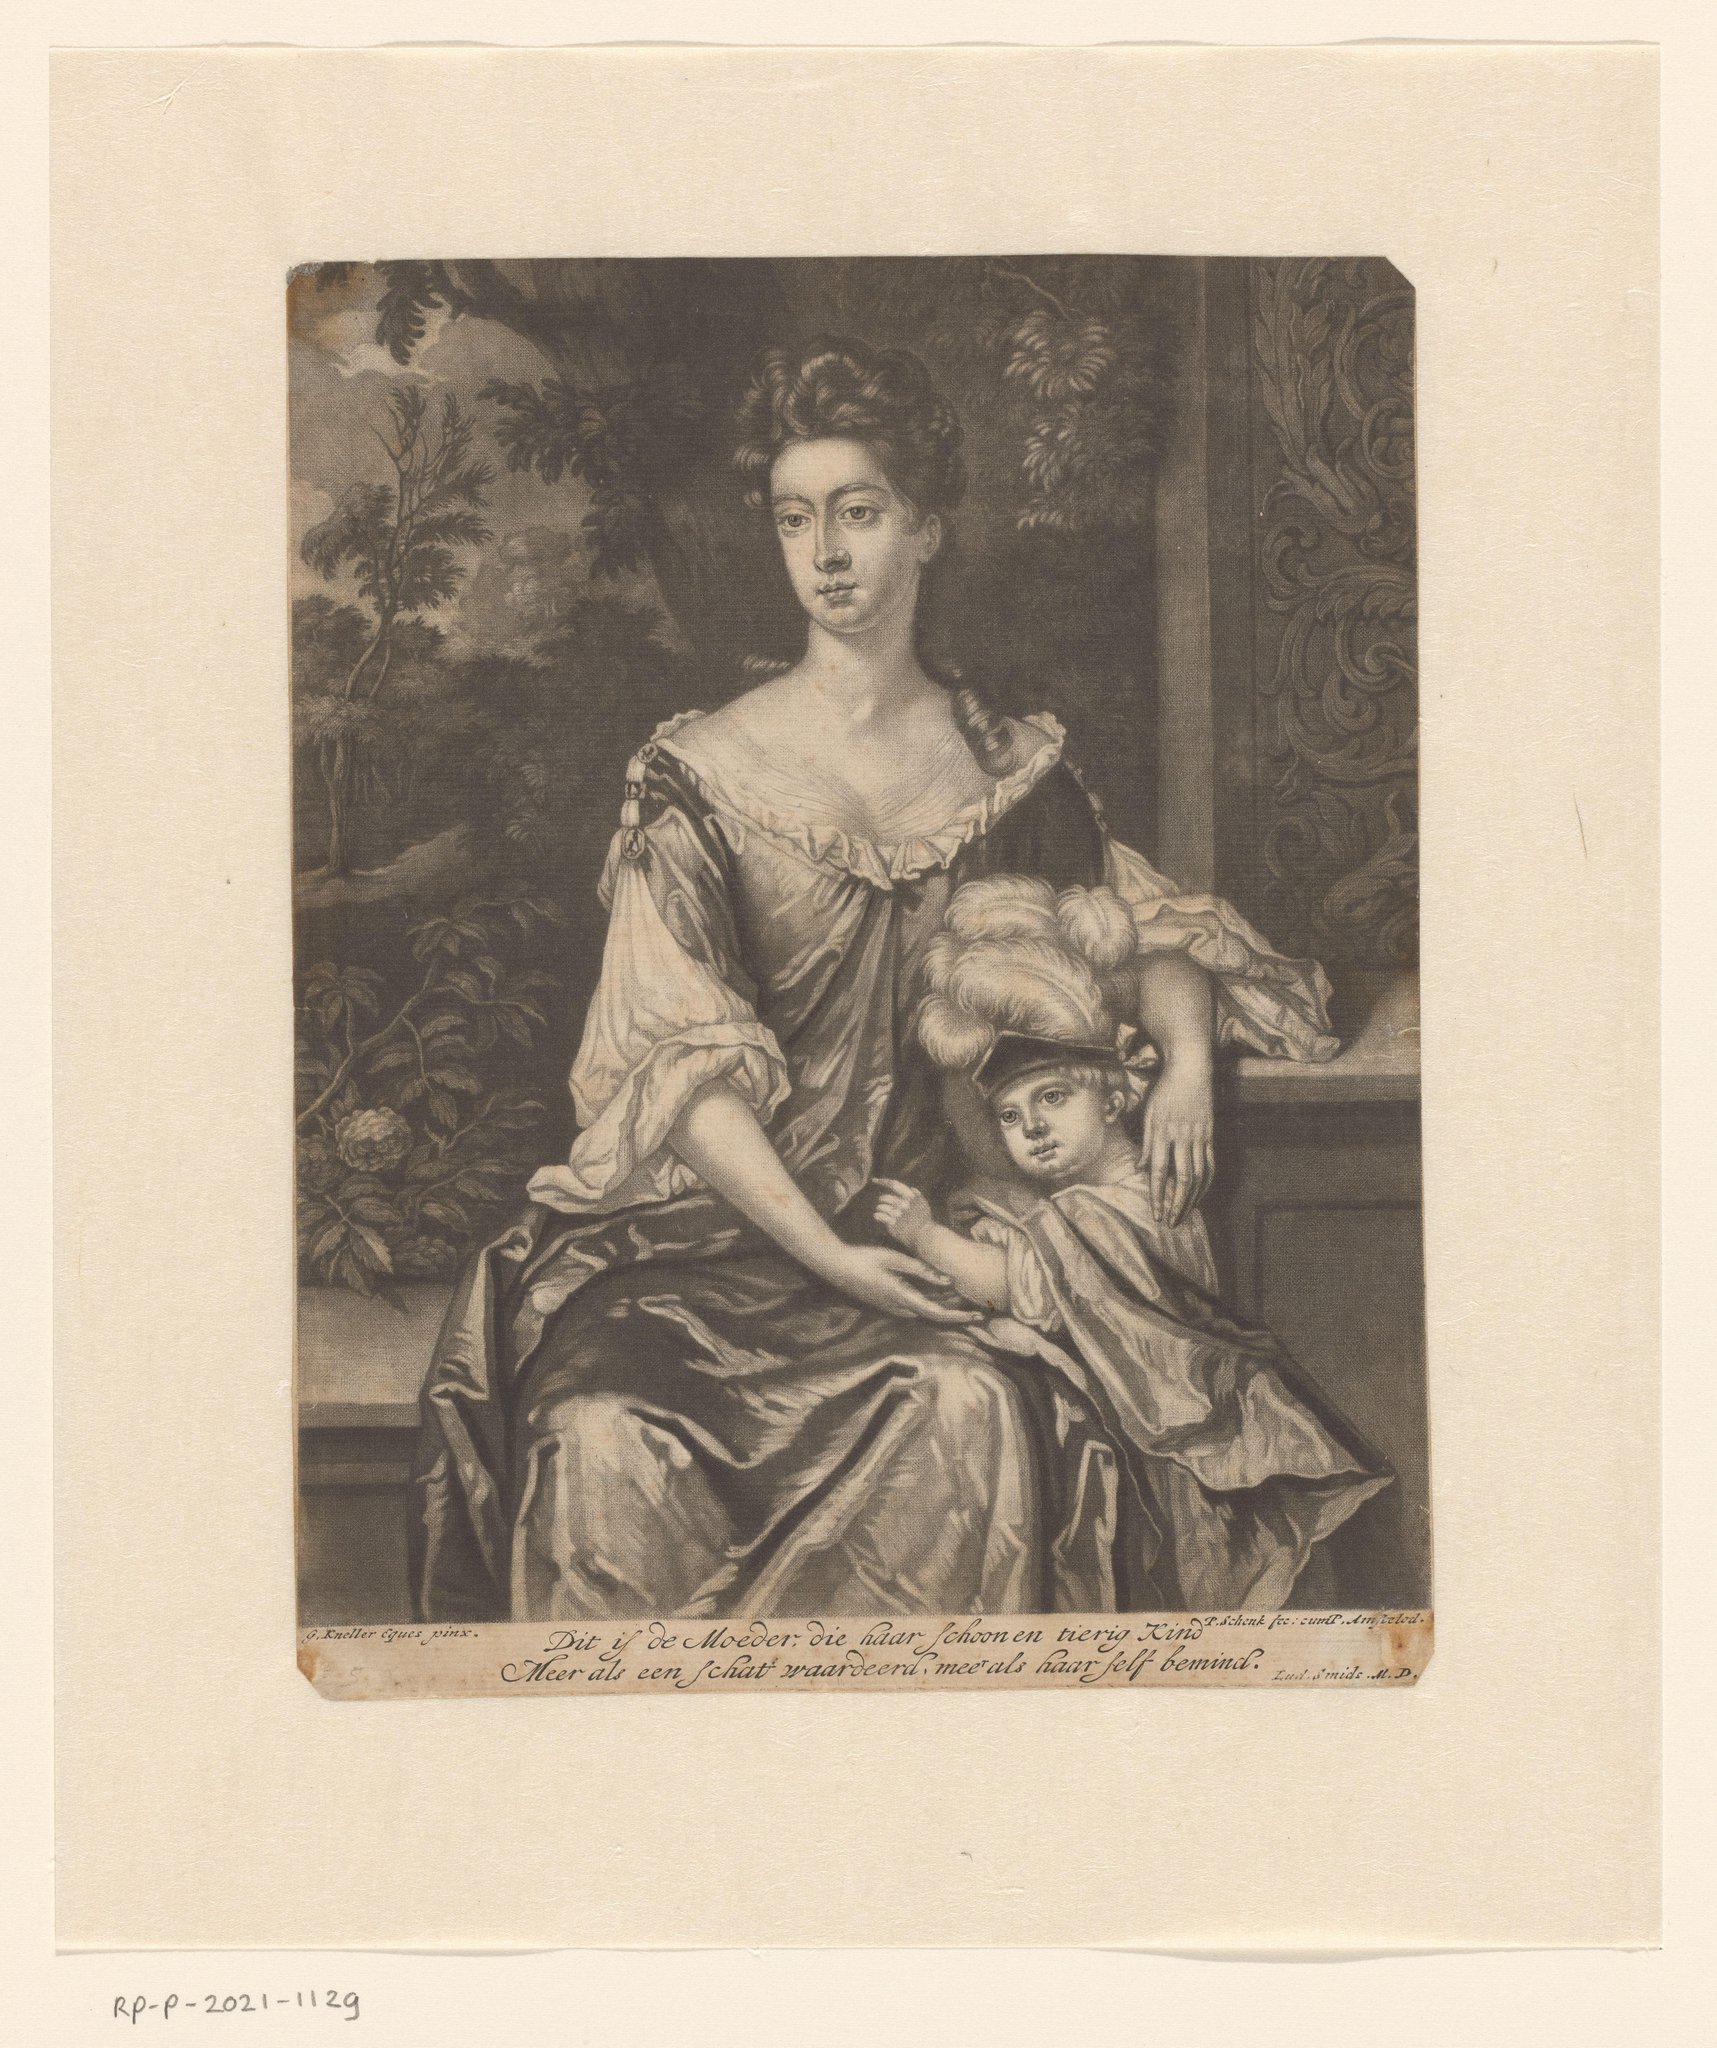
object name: print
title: Moeder met kind zittend in een tuin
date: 1695-1711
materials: paper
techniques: engraving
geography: amsterdam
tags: mother with son(s) and daughter(s) (mother-love), english or landscape garden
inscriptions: collector's mark: Lugt 2228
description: Met tweeregelig vers in het Nederlands onder de prent.